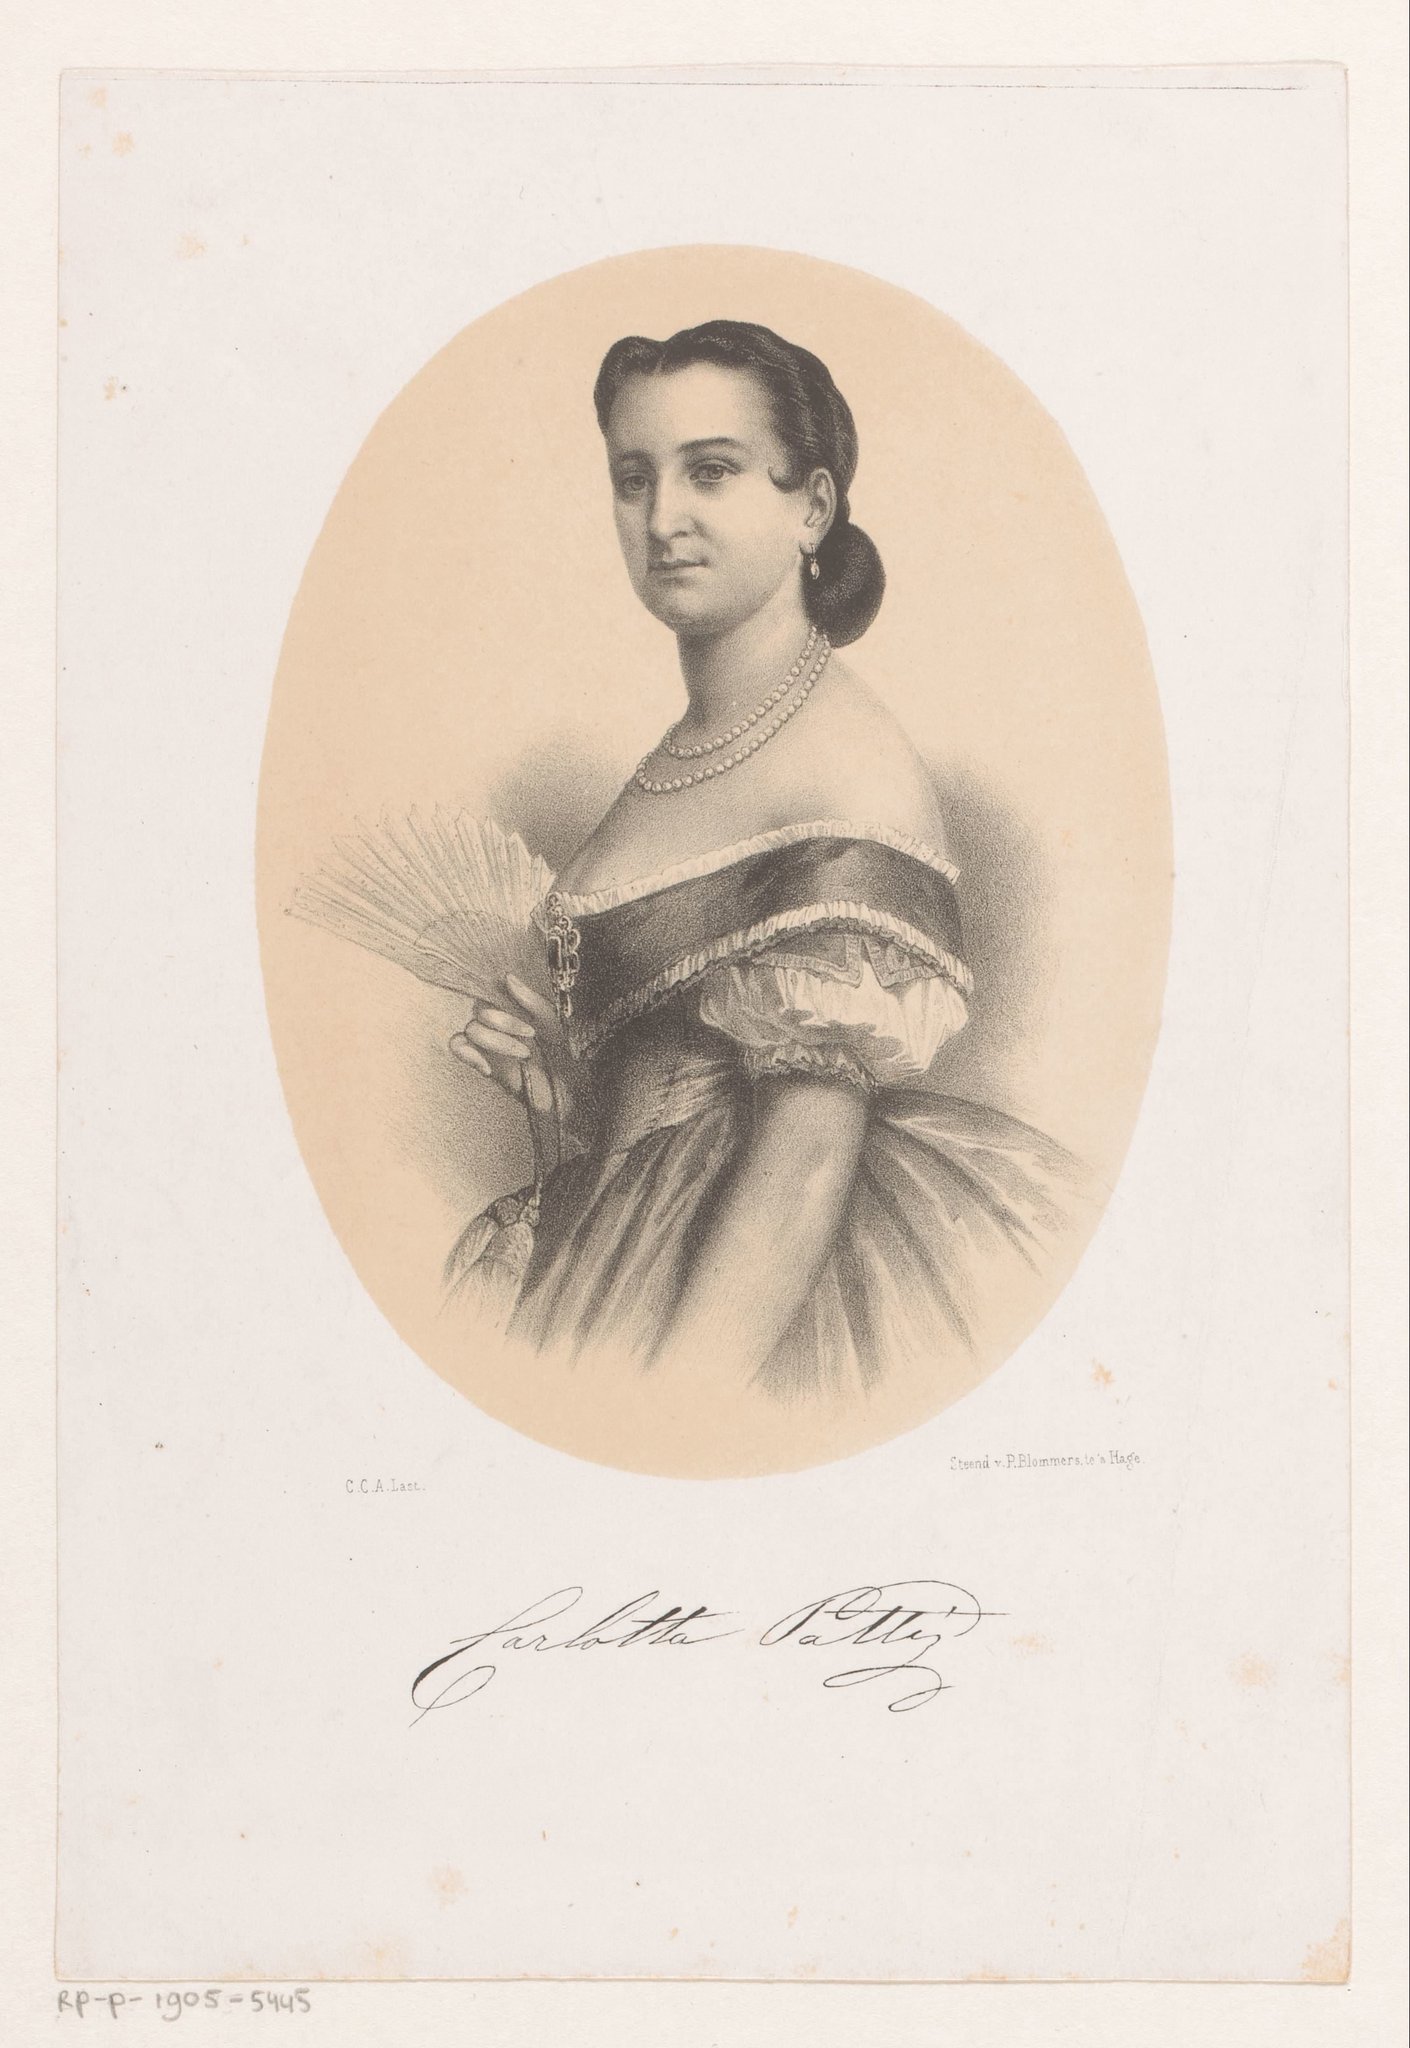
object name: print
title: Portret van Carlotta Patti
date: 1843-1876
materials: paper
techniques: tone lithography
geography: the hague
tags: fan, historical persons (+ half-length portrait)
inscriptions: collector's mark: Lugt 2228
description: De geportretteerde heeft een waaier in haar rechterhand. Onder het portret haar signatuur.